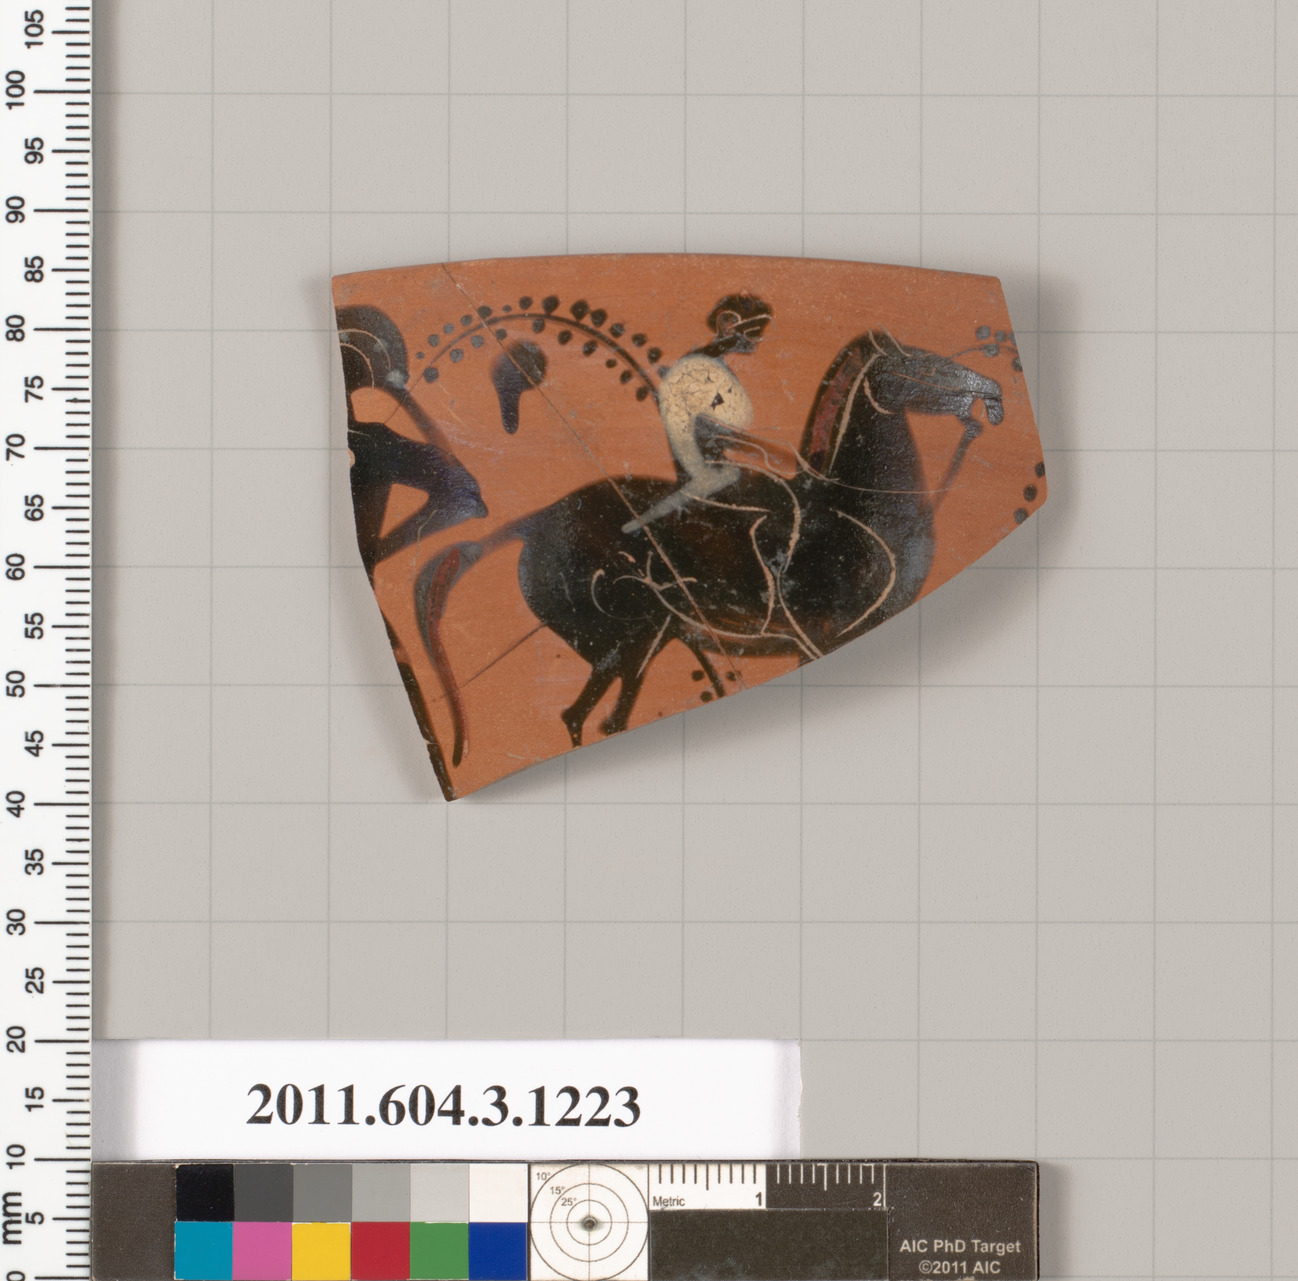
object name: kyathos fragment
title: Terracotta rim fragment of a kyathos (cup-shaped ladle)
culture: greek, attic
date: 534-468 BCE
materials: terracotta